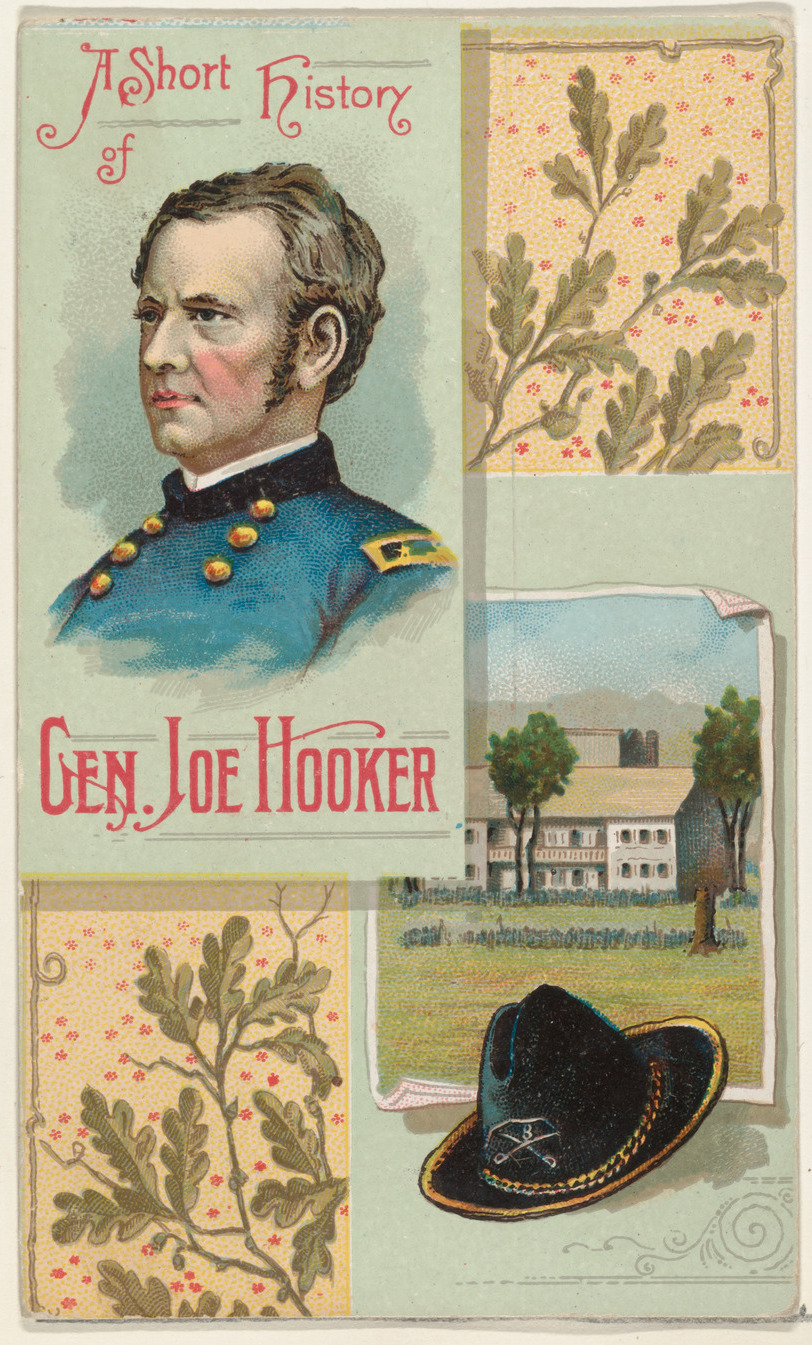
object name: print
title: A Short History: General Joseph Hooker, from the Histories of Generals series (N114) issued by W. Duke, Sons & Co. to promote Honest Long Cut Smoking and Chewing Tobacco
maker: w. duke, sons & co.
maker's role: publisher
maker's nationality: american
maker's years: 1870-1920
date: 1888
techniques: color lithograph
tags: hats,men,portraits,leaves,generals